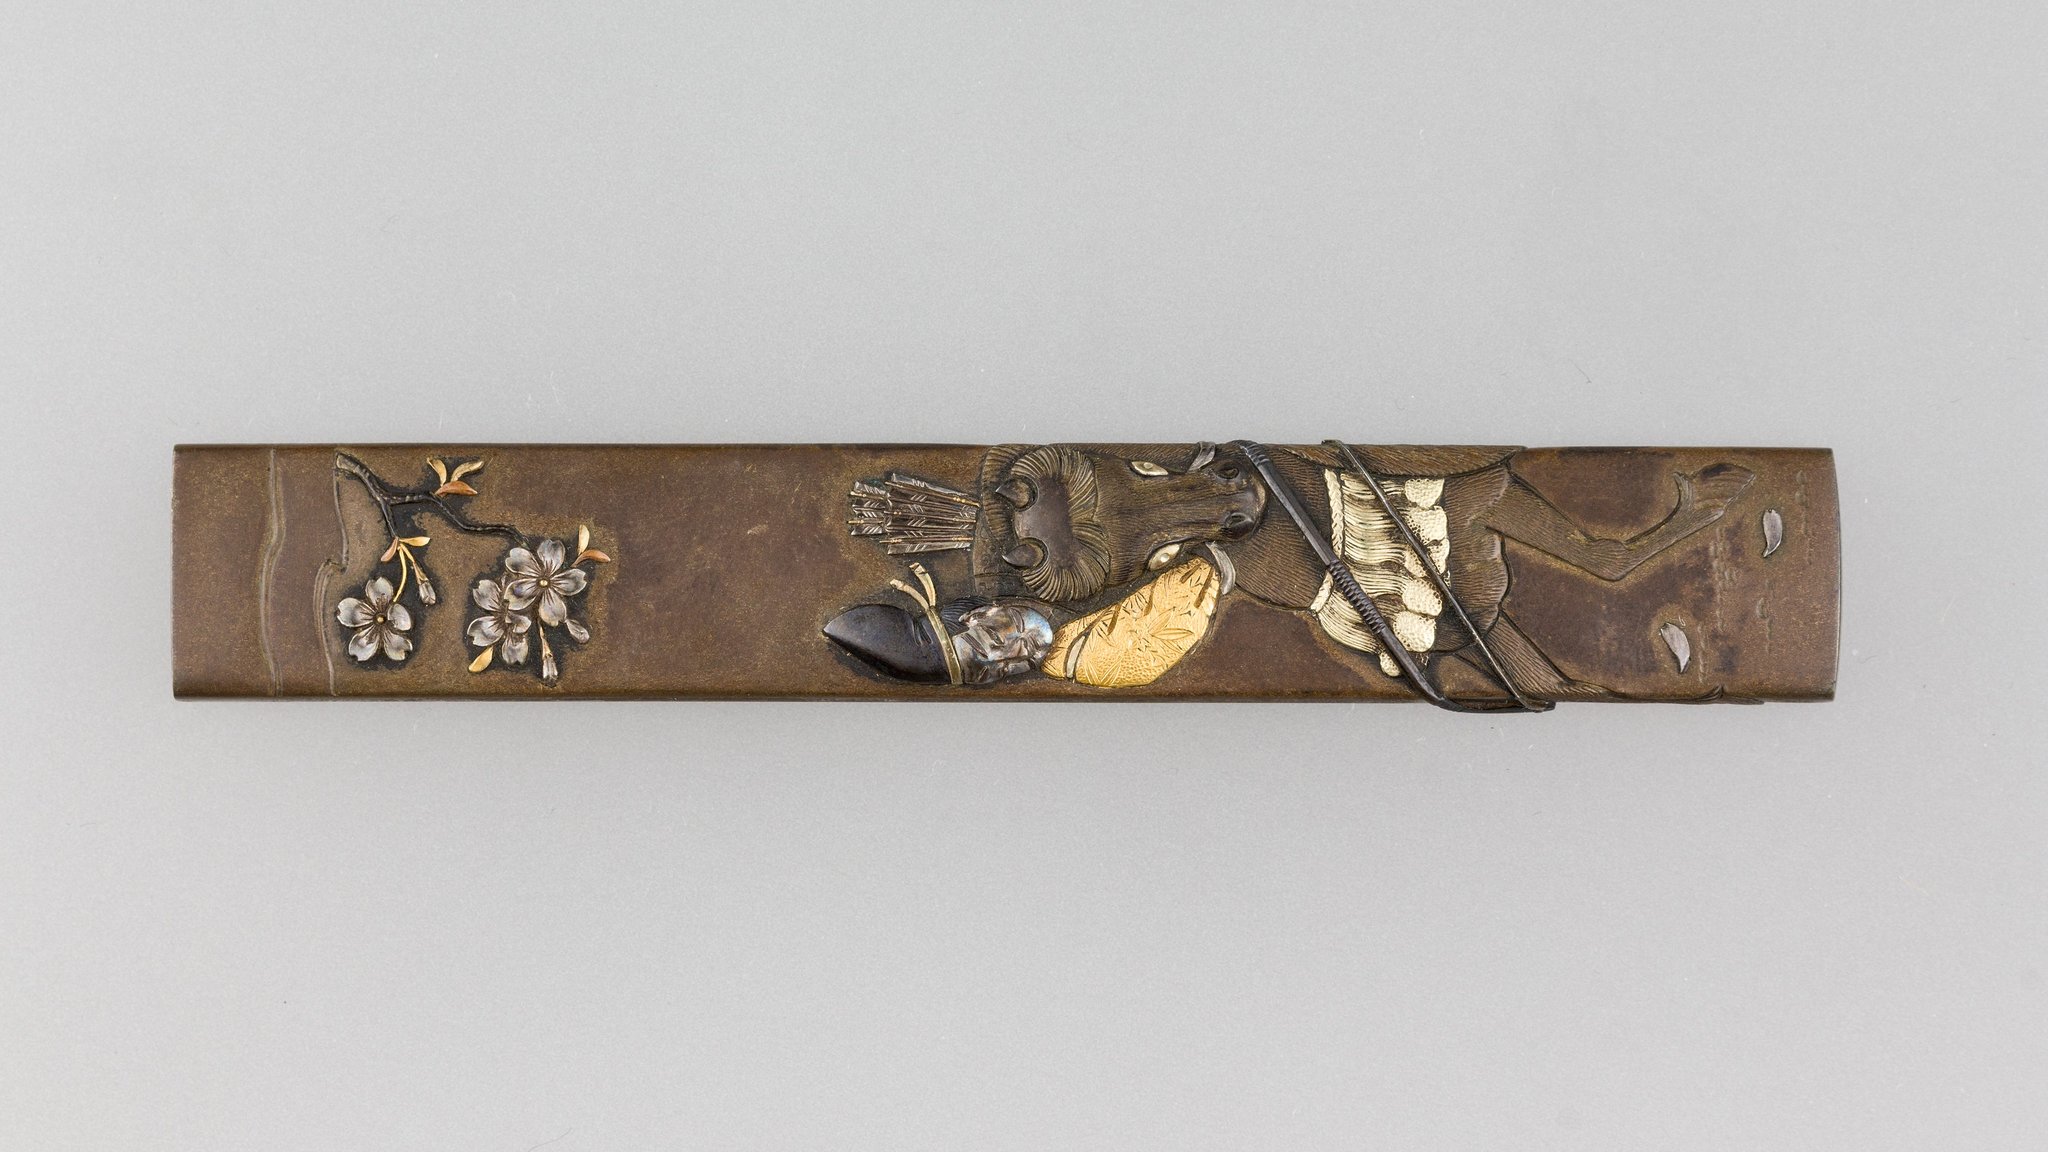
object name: knife handle kozuka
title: Knife Handle (Kozuka)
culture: japanese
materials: gold alloy, silver alloy, gold, silver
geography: japan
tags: men,flowers